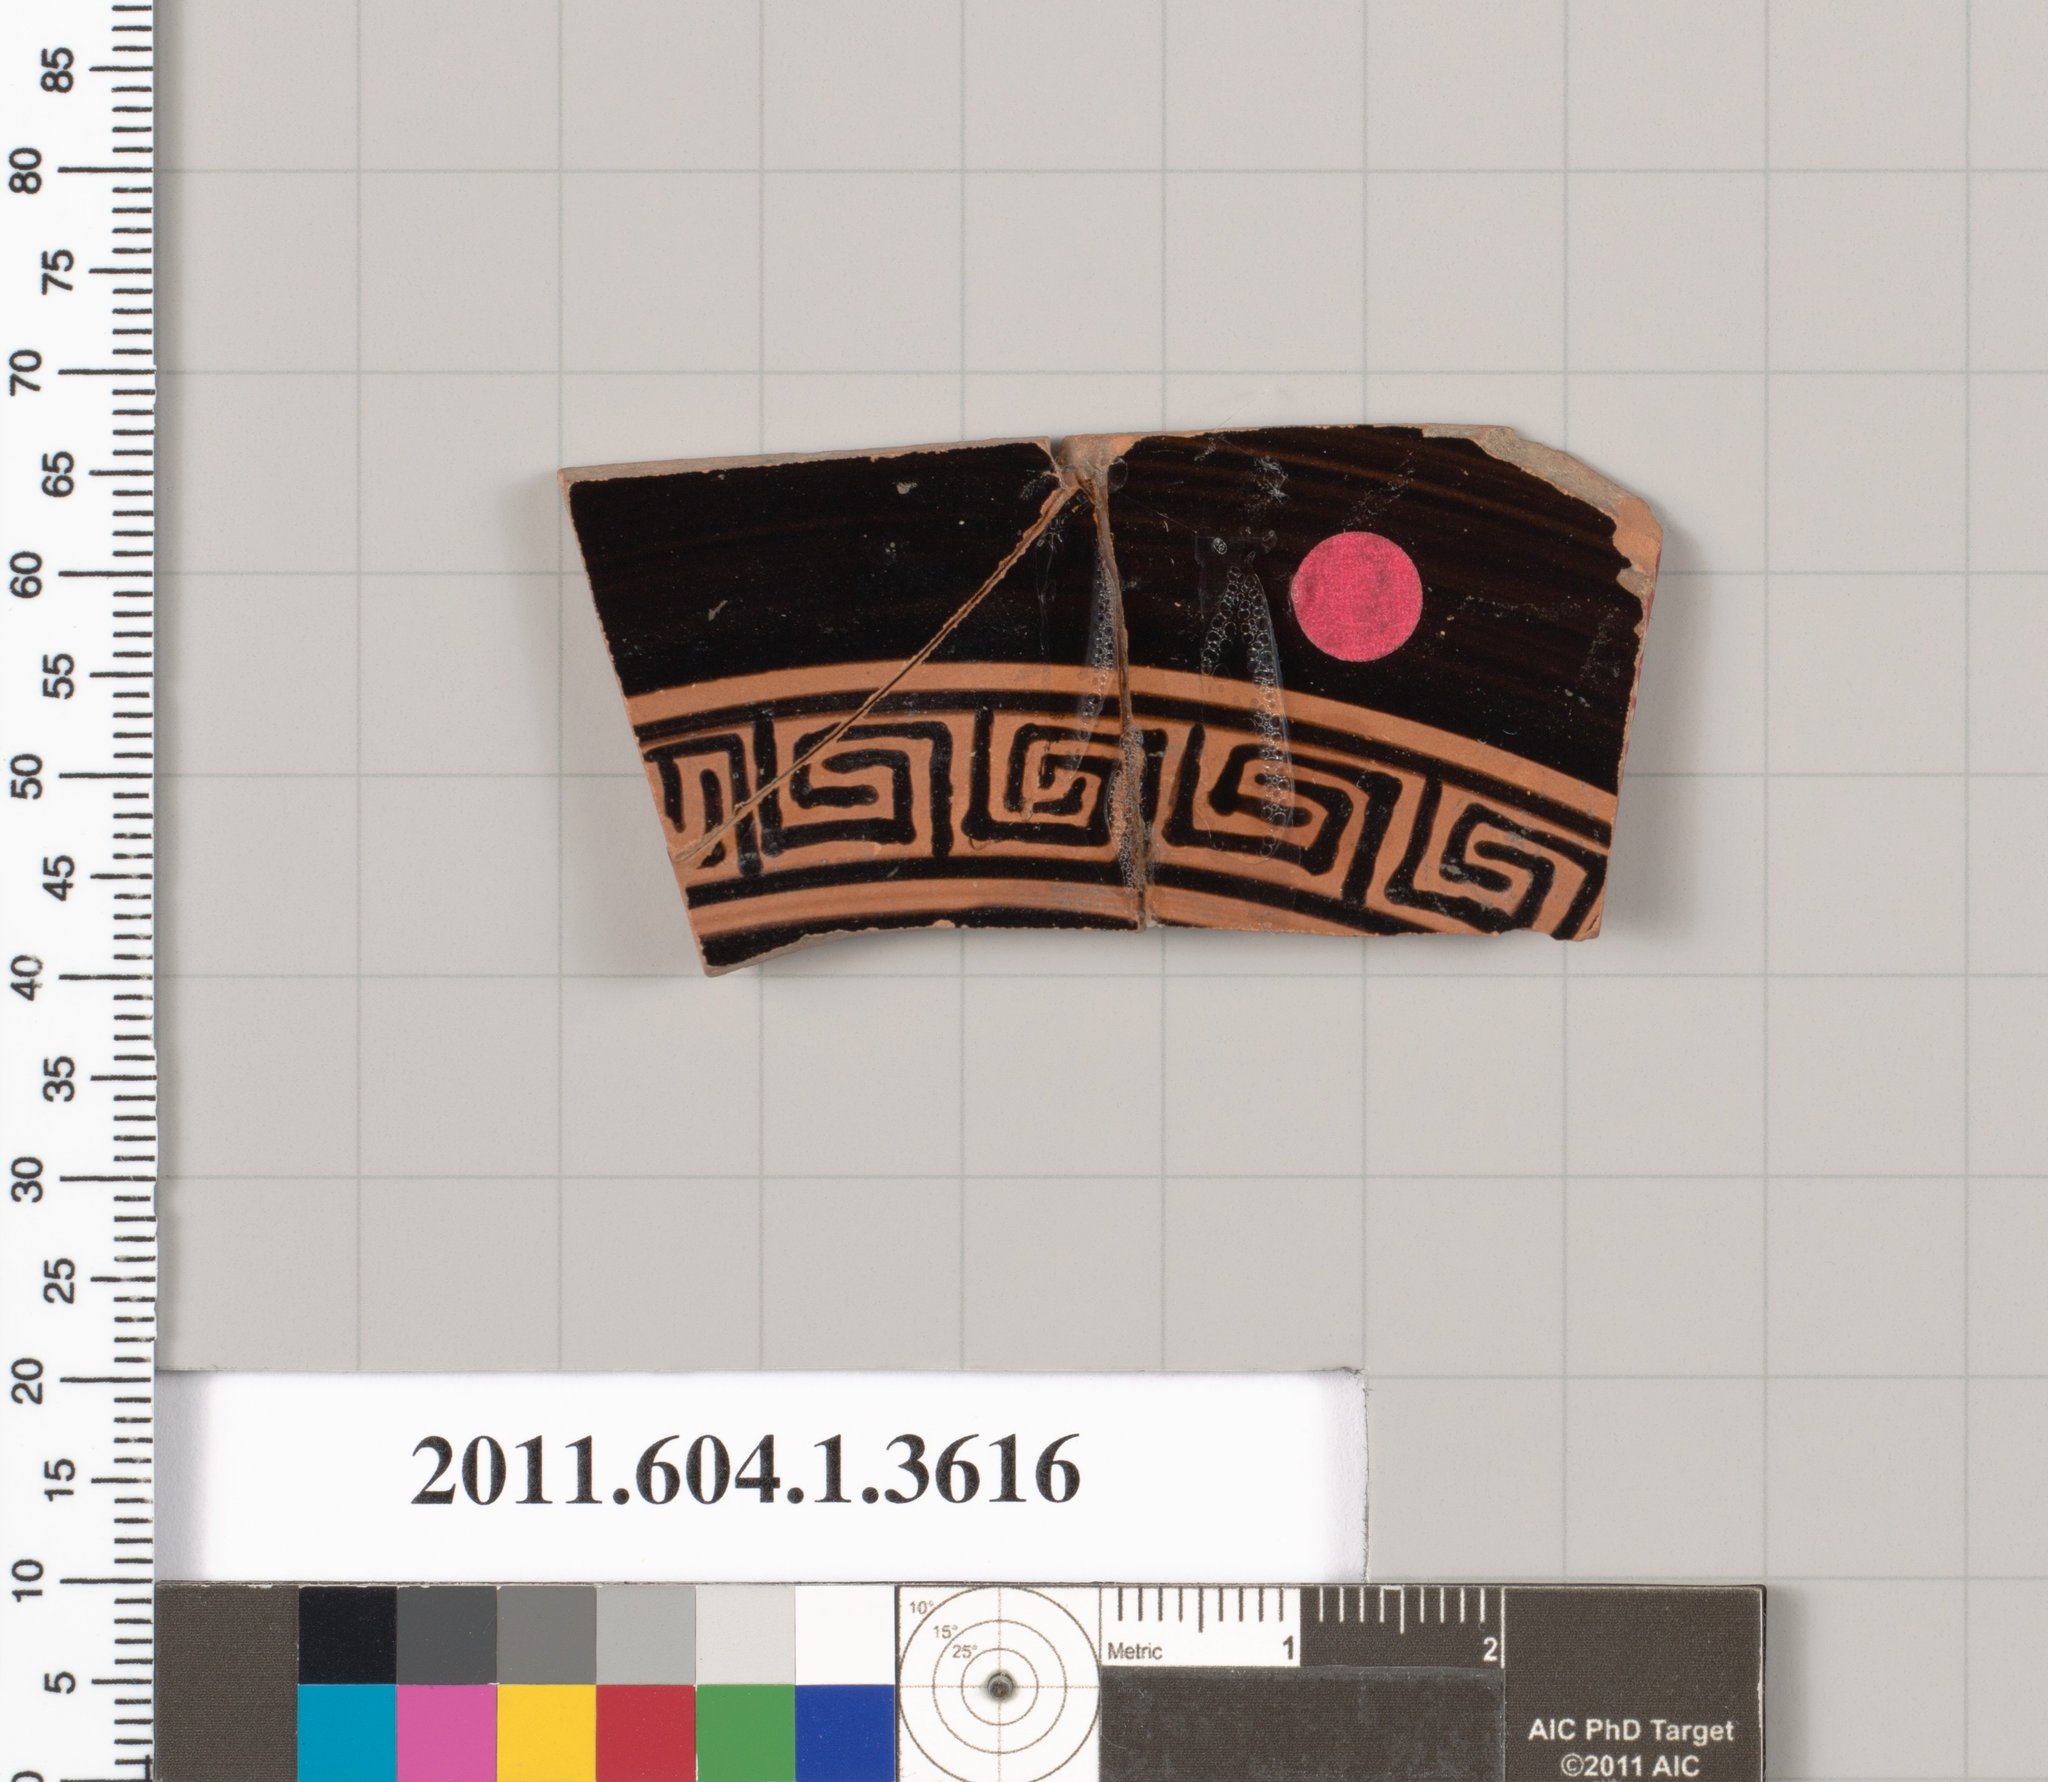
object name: kylix fragment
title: Terracotta fragment of a kylix (drinking cup)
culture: greek, attic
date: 500-480 BCE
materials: terracotta